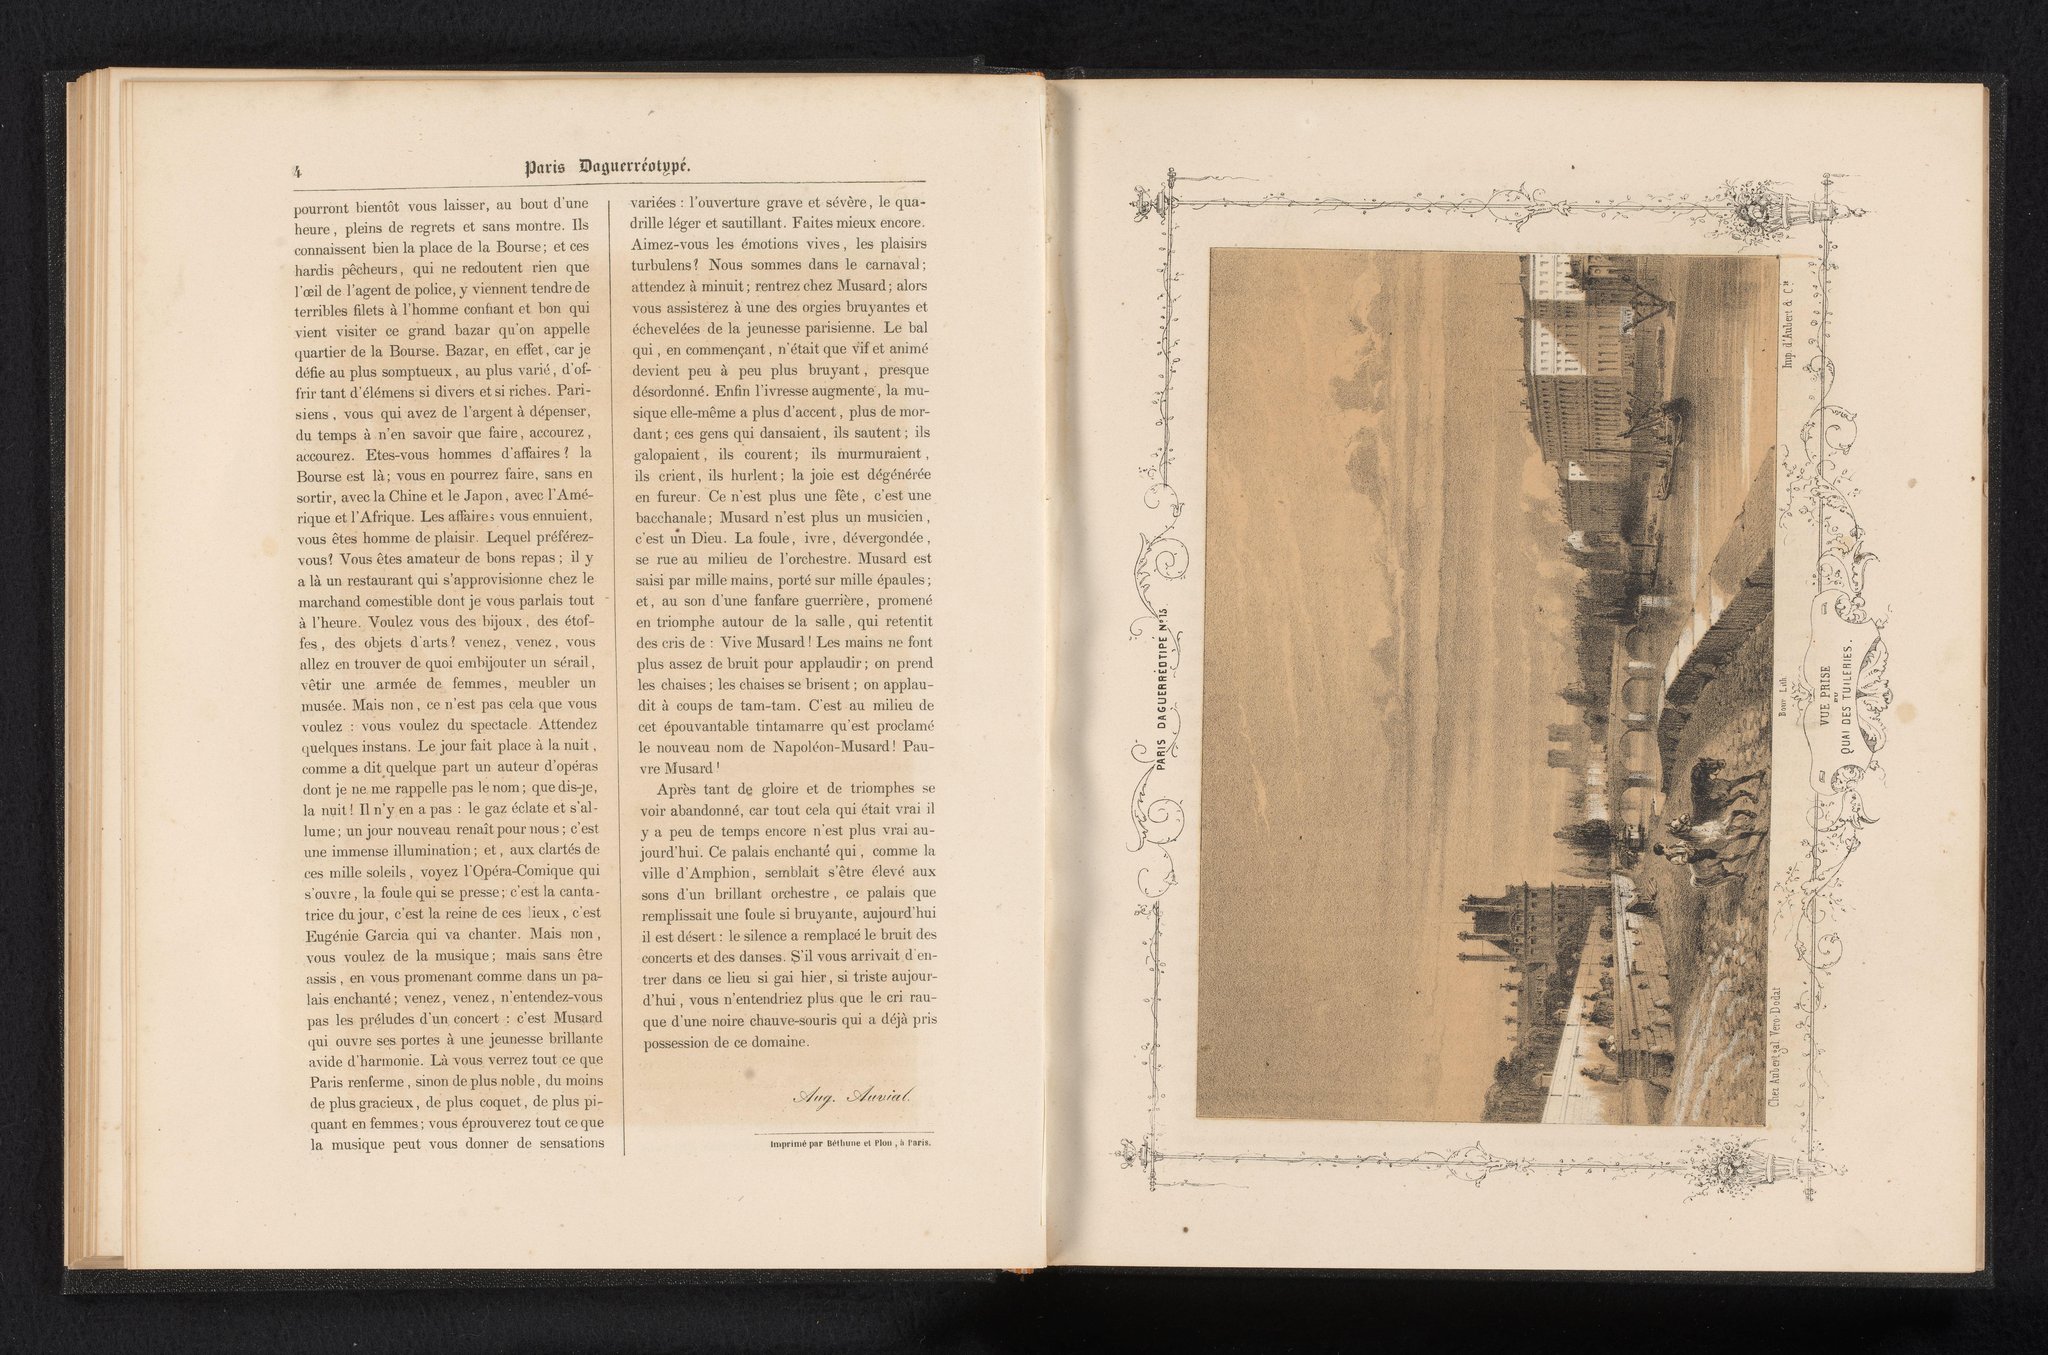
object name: print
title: Vue pris du Quai des Tuileries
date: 1839-1840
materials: paper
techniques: tone lithography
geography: paris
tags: quay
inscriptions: inscription: ‘PARIS DAGUERRÉOTYPÉ No. 15.’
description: Prent op zevenenvijftigste ongenummerde pagina.